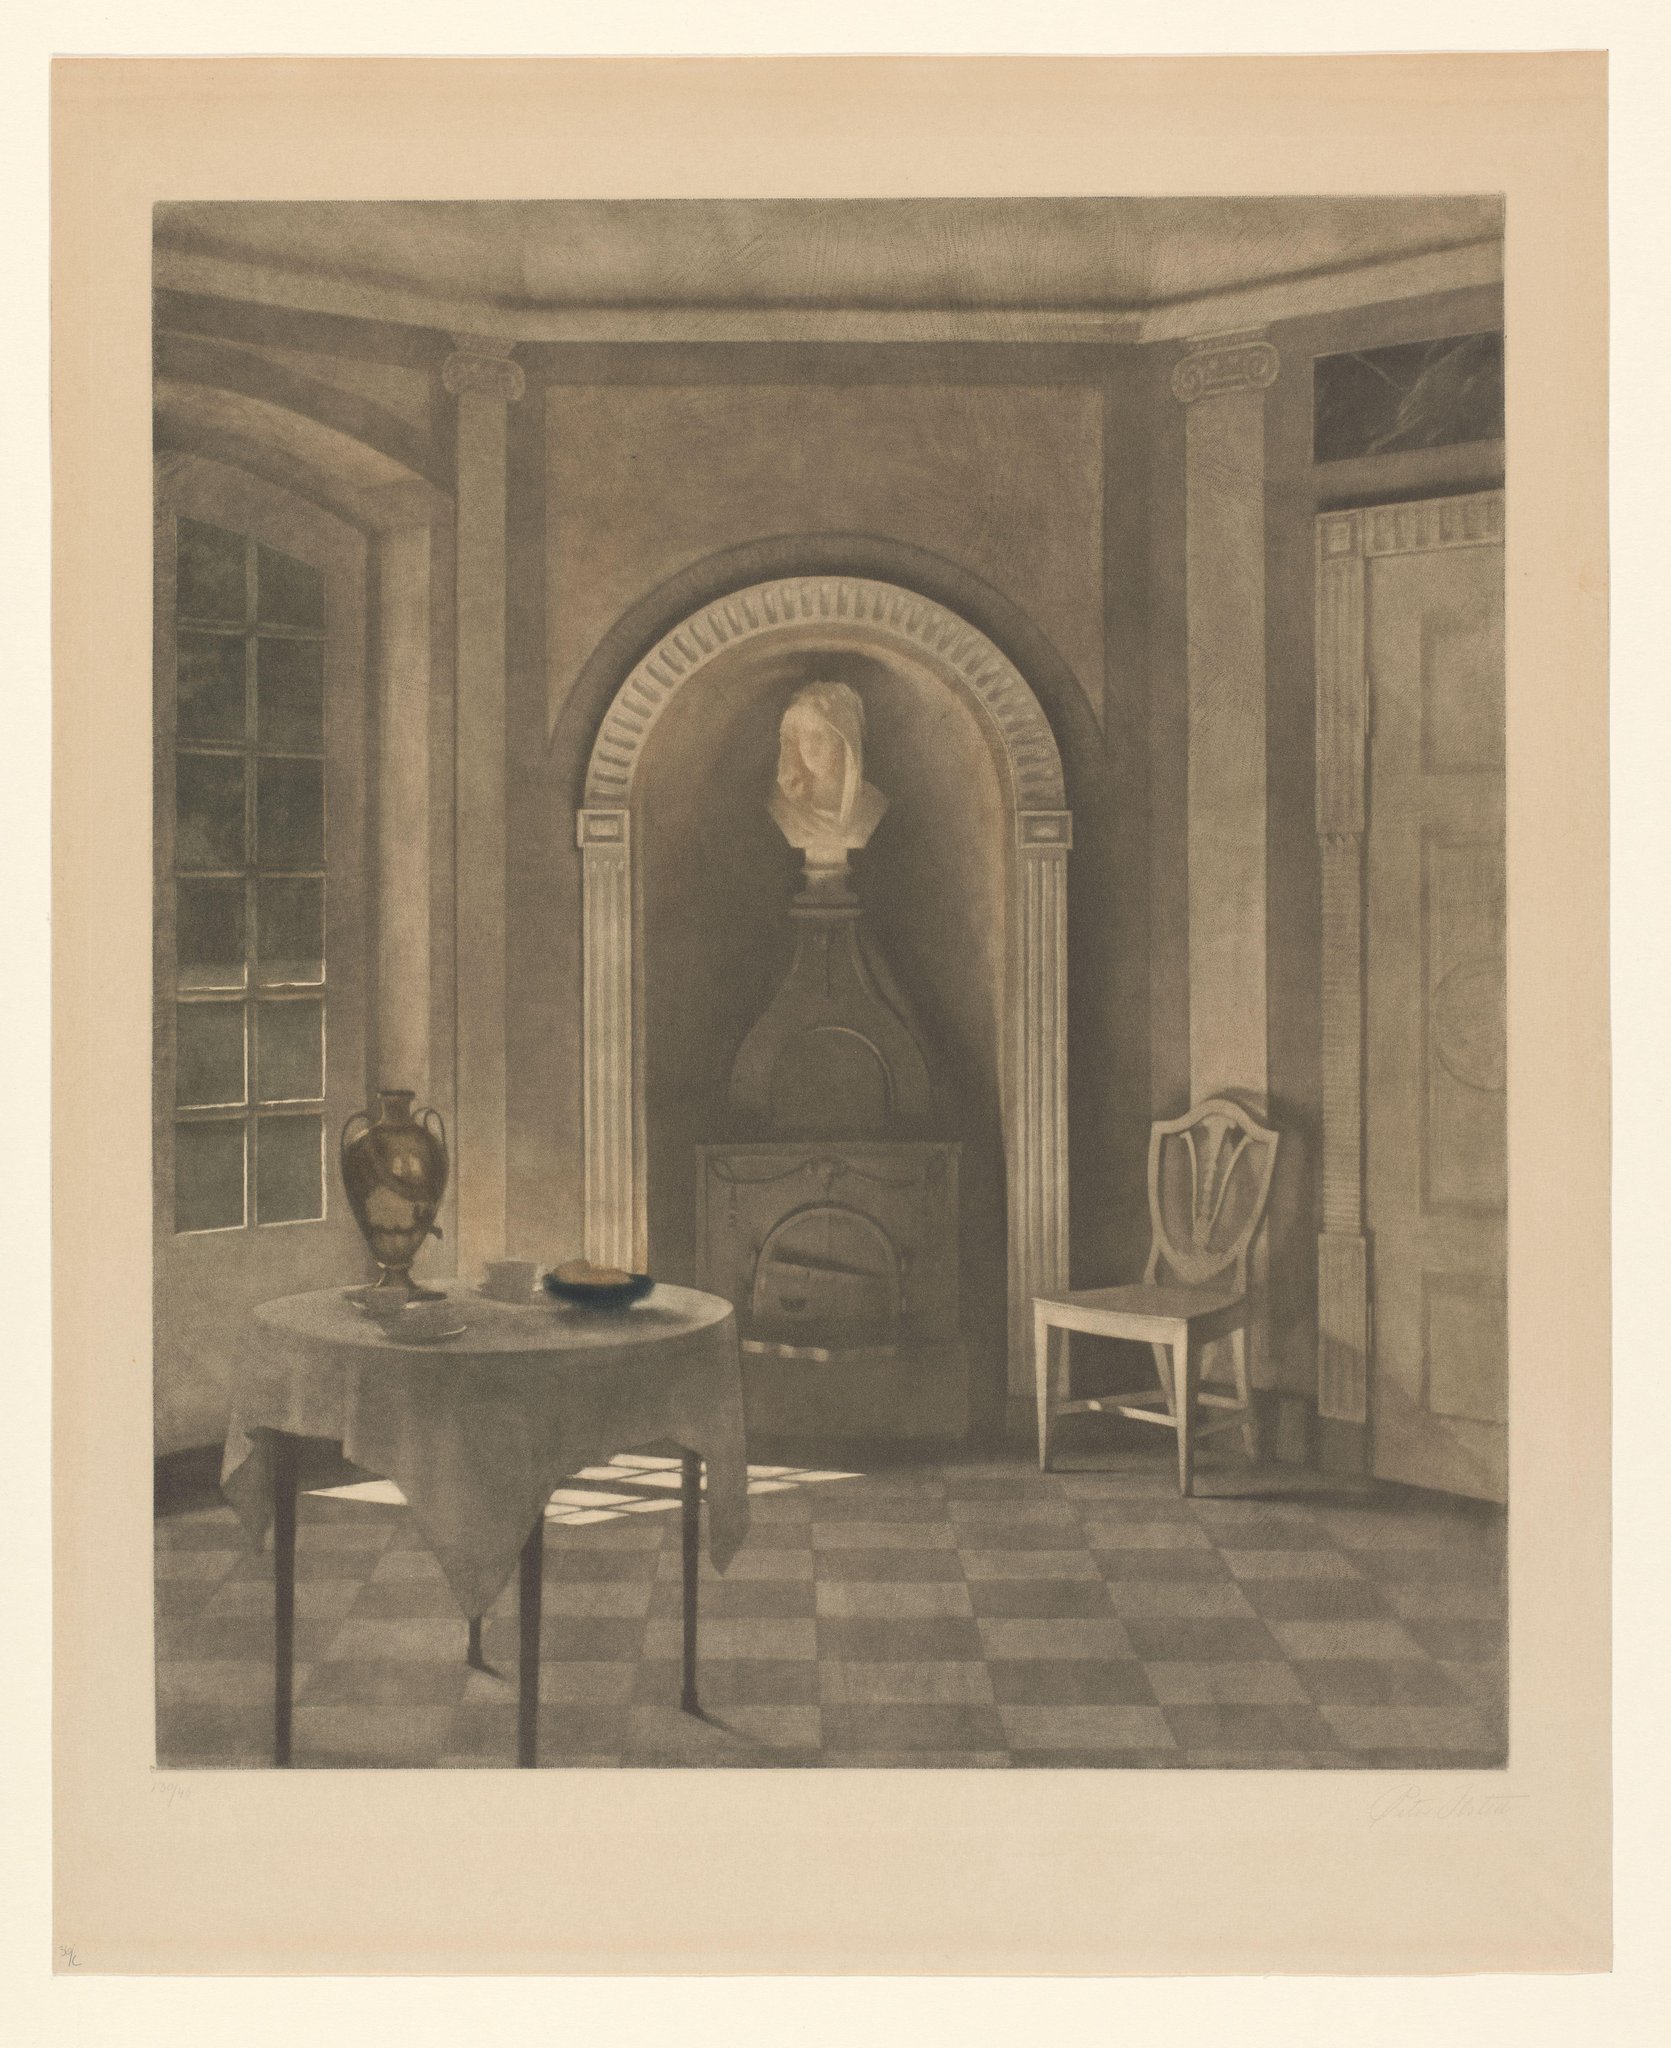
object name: print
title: Interieur van een woning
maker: peter vilhelm ilsted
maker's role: print maker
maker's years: 1861-1933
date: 1871-1933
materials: paper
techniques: color mezzotint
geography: denmark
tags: urban housing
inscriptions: collector's mark: Lugt 2760, collector's mark: Lugt 2228